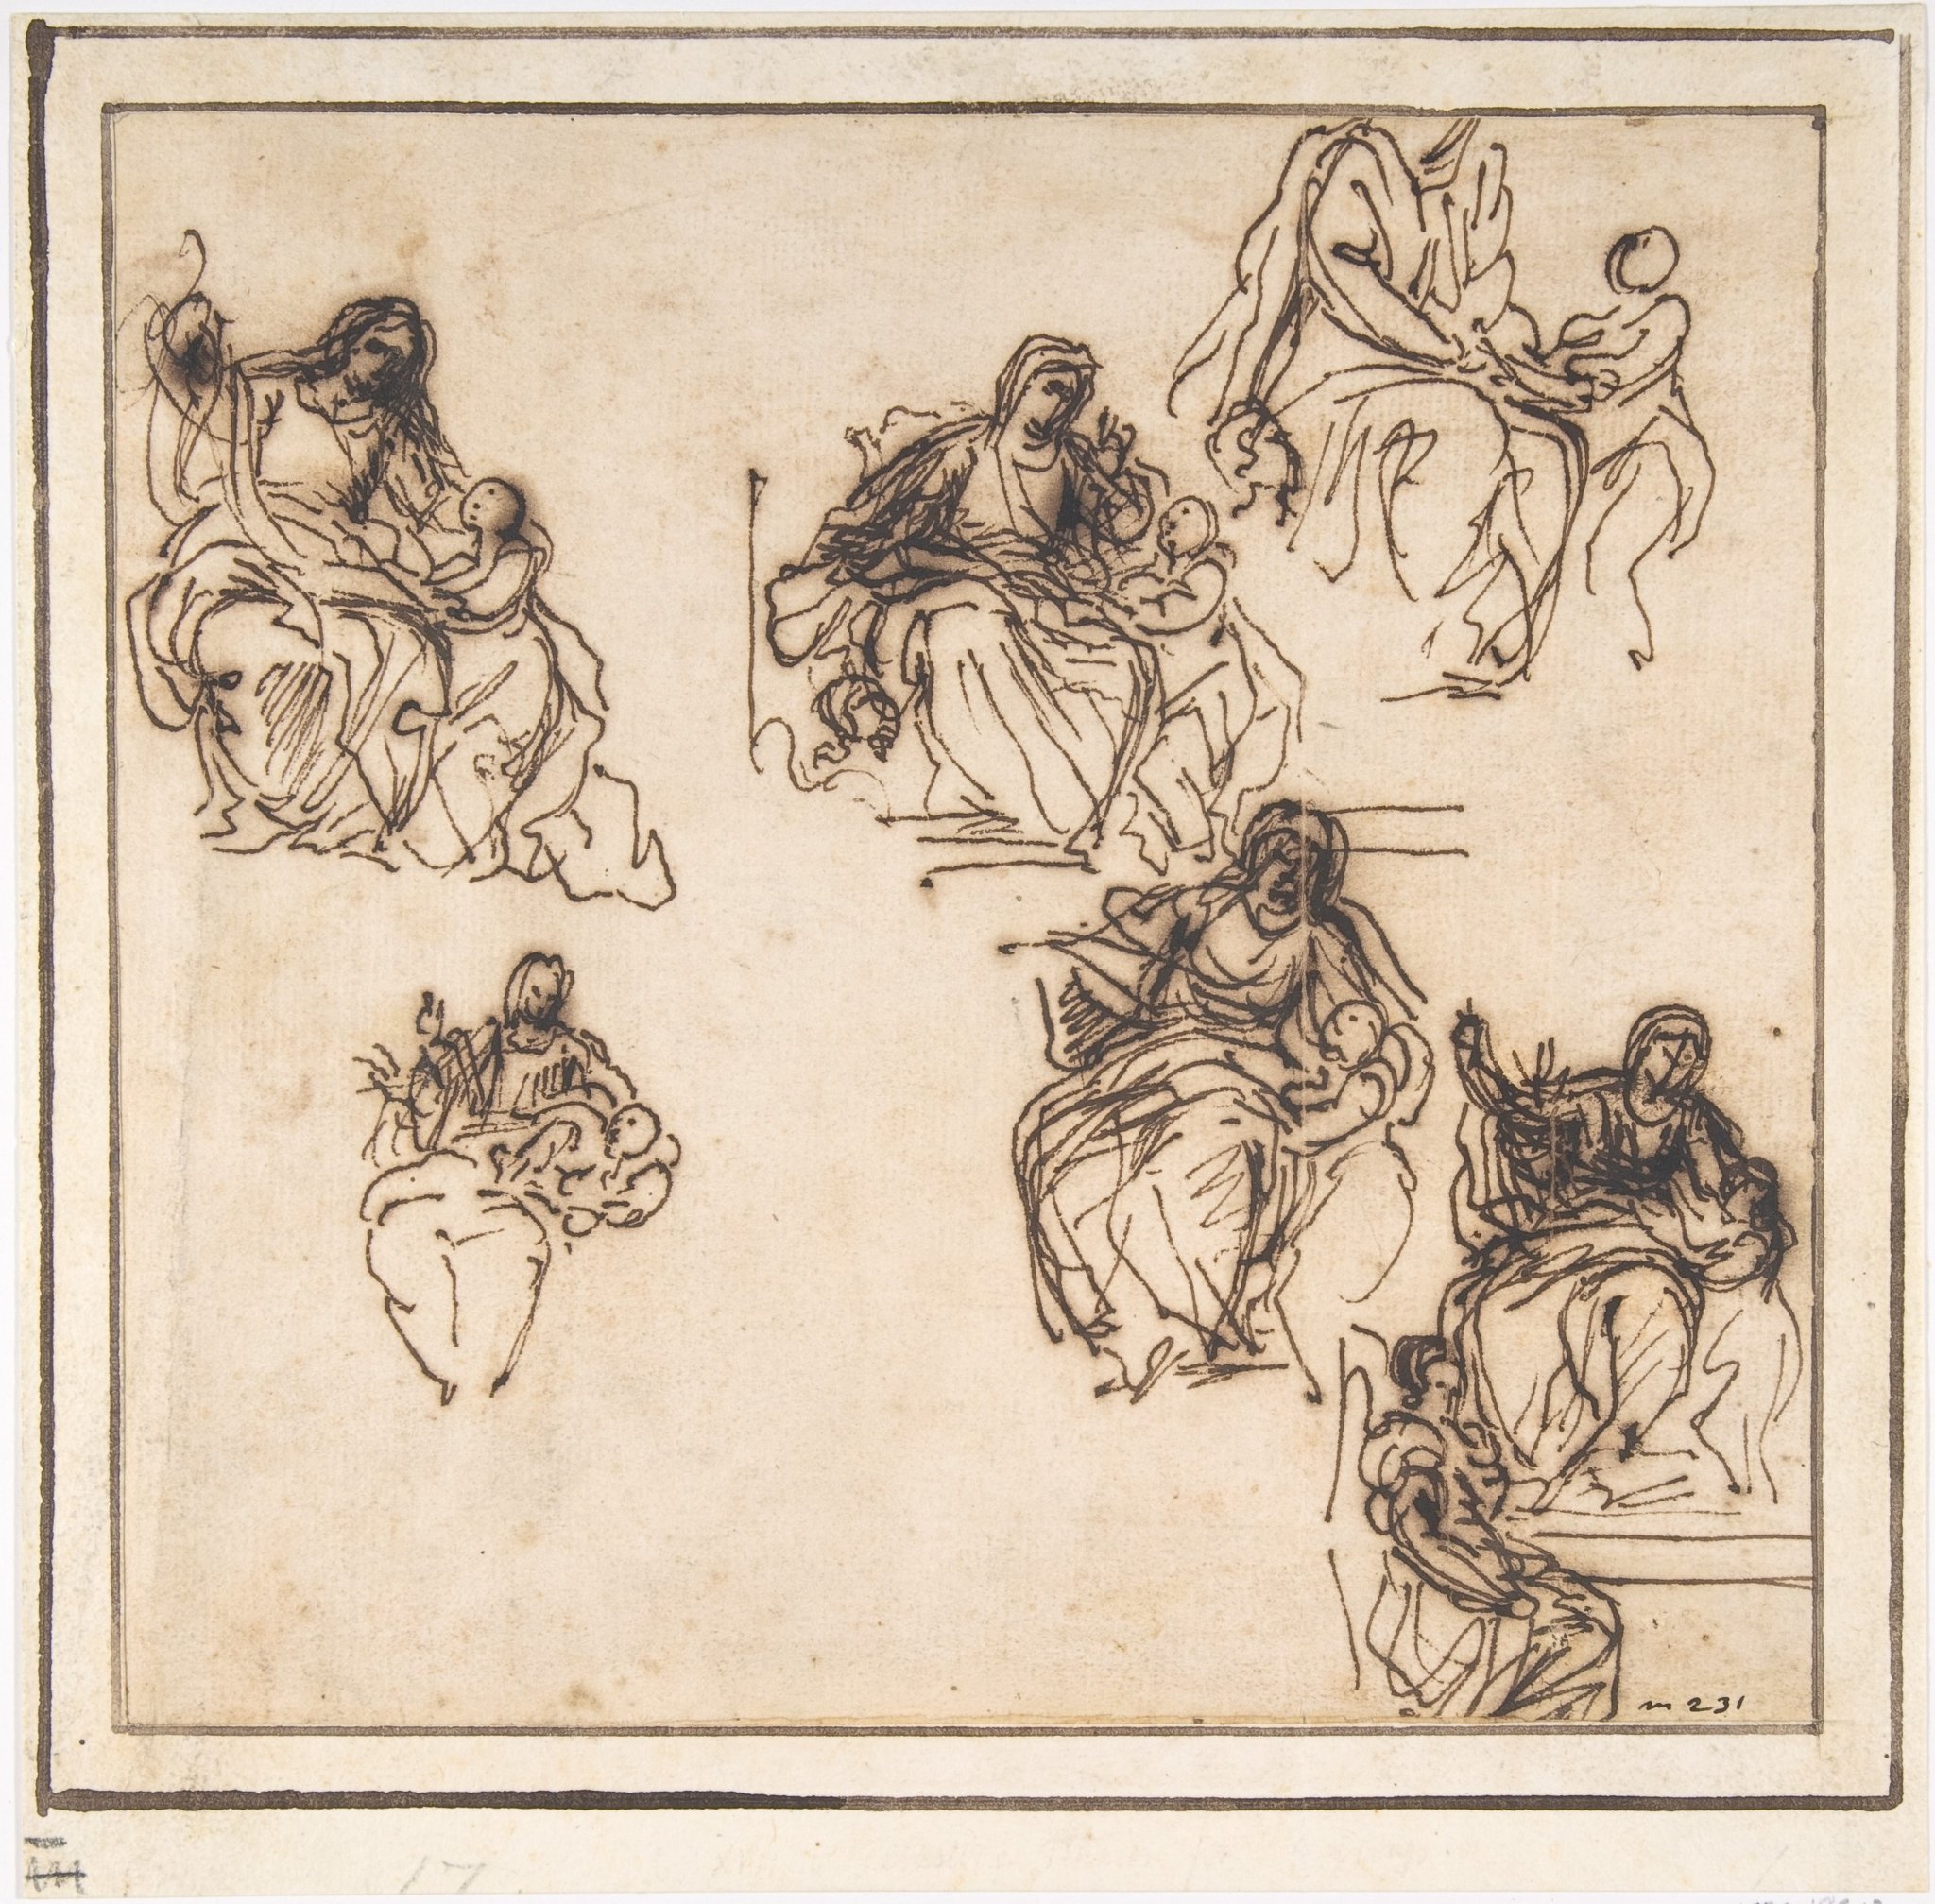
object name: drawing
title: Studies for the Education of the Virgin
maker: agostino masucci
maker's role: artist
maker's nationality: italian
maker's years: 1692-1768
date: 1692-1758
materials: ink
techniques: pen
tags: madonna and child,virgin mary